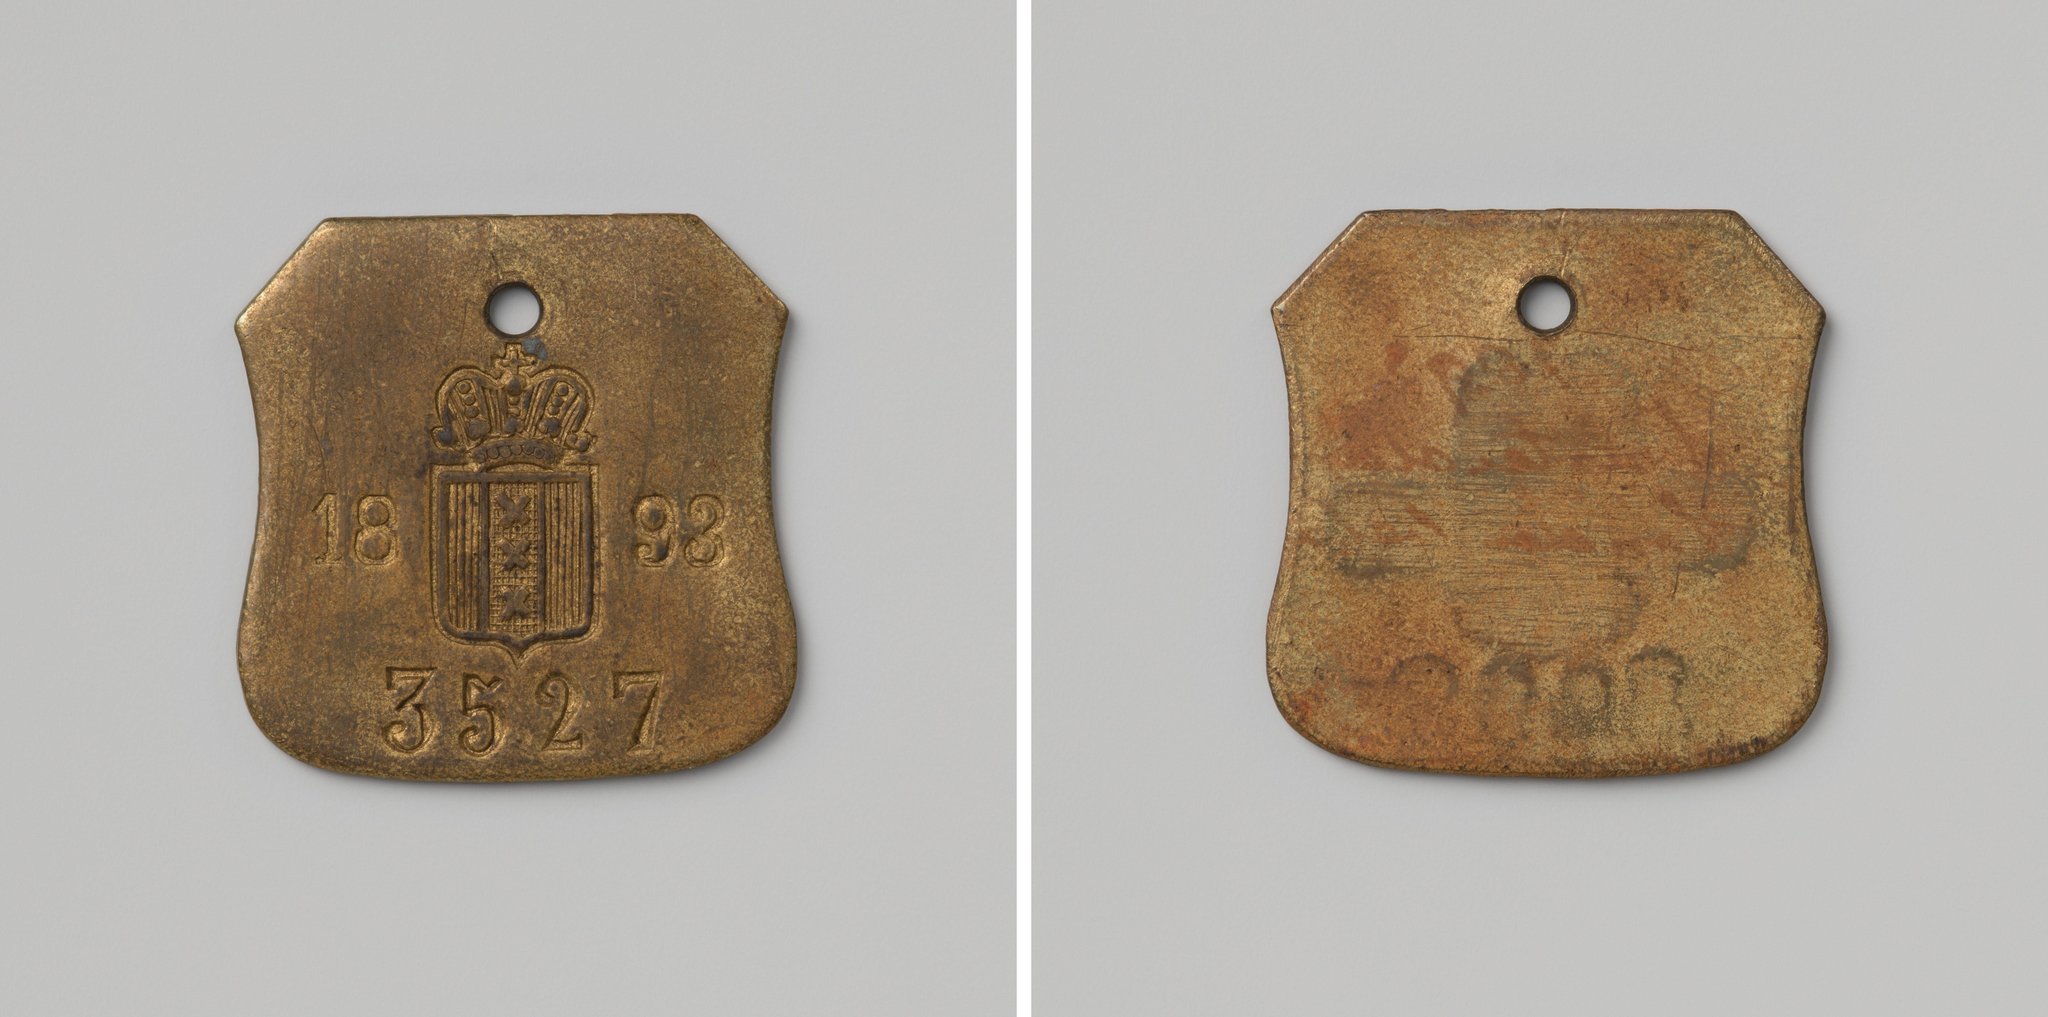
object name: tax token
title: Stad Amsterdam, loodje met no. 3527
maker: Anonymous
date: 1893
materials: brass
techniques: striking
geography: amsterdam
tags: amsterdam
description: eenzijdig, ruitvormig loodje met holle zijden, aan bovenzijde afgeschuinde hoeken en gat, en aan onderzijde afgeronde hoeken. Voorzijde: gekroond wapenschild tussen jaartal boven cijfer 3527. Keerzijde: blanco